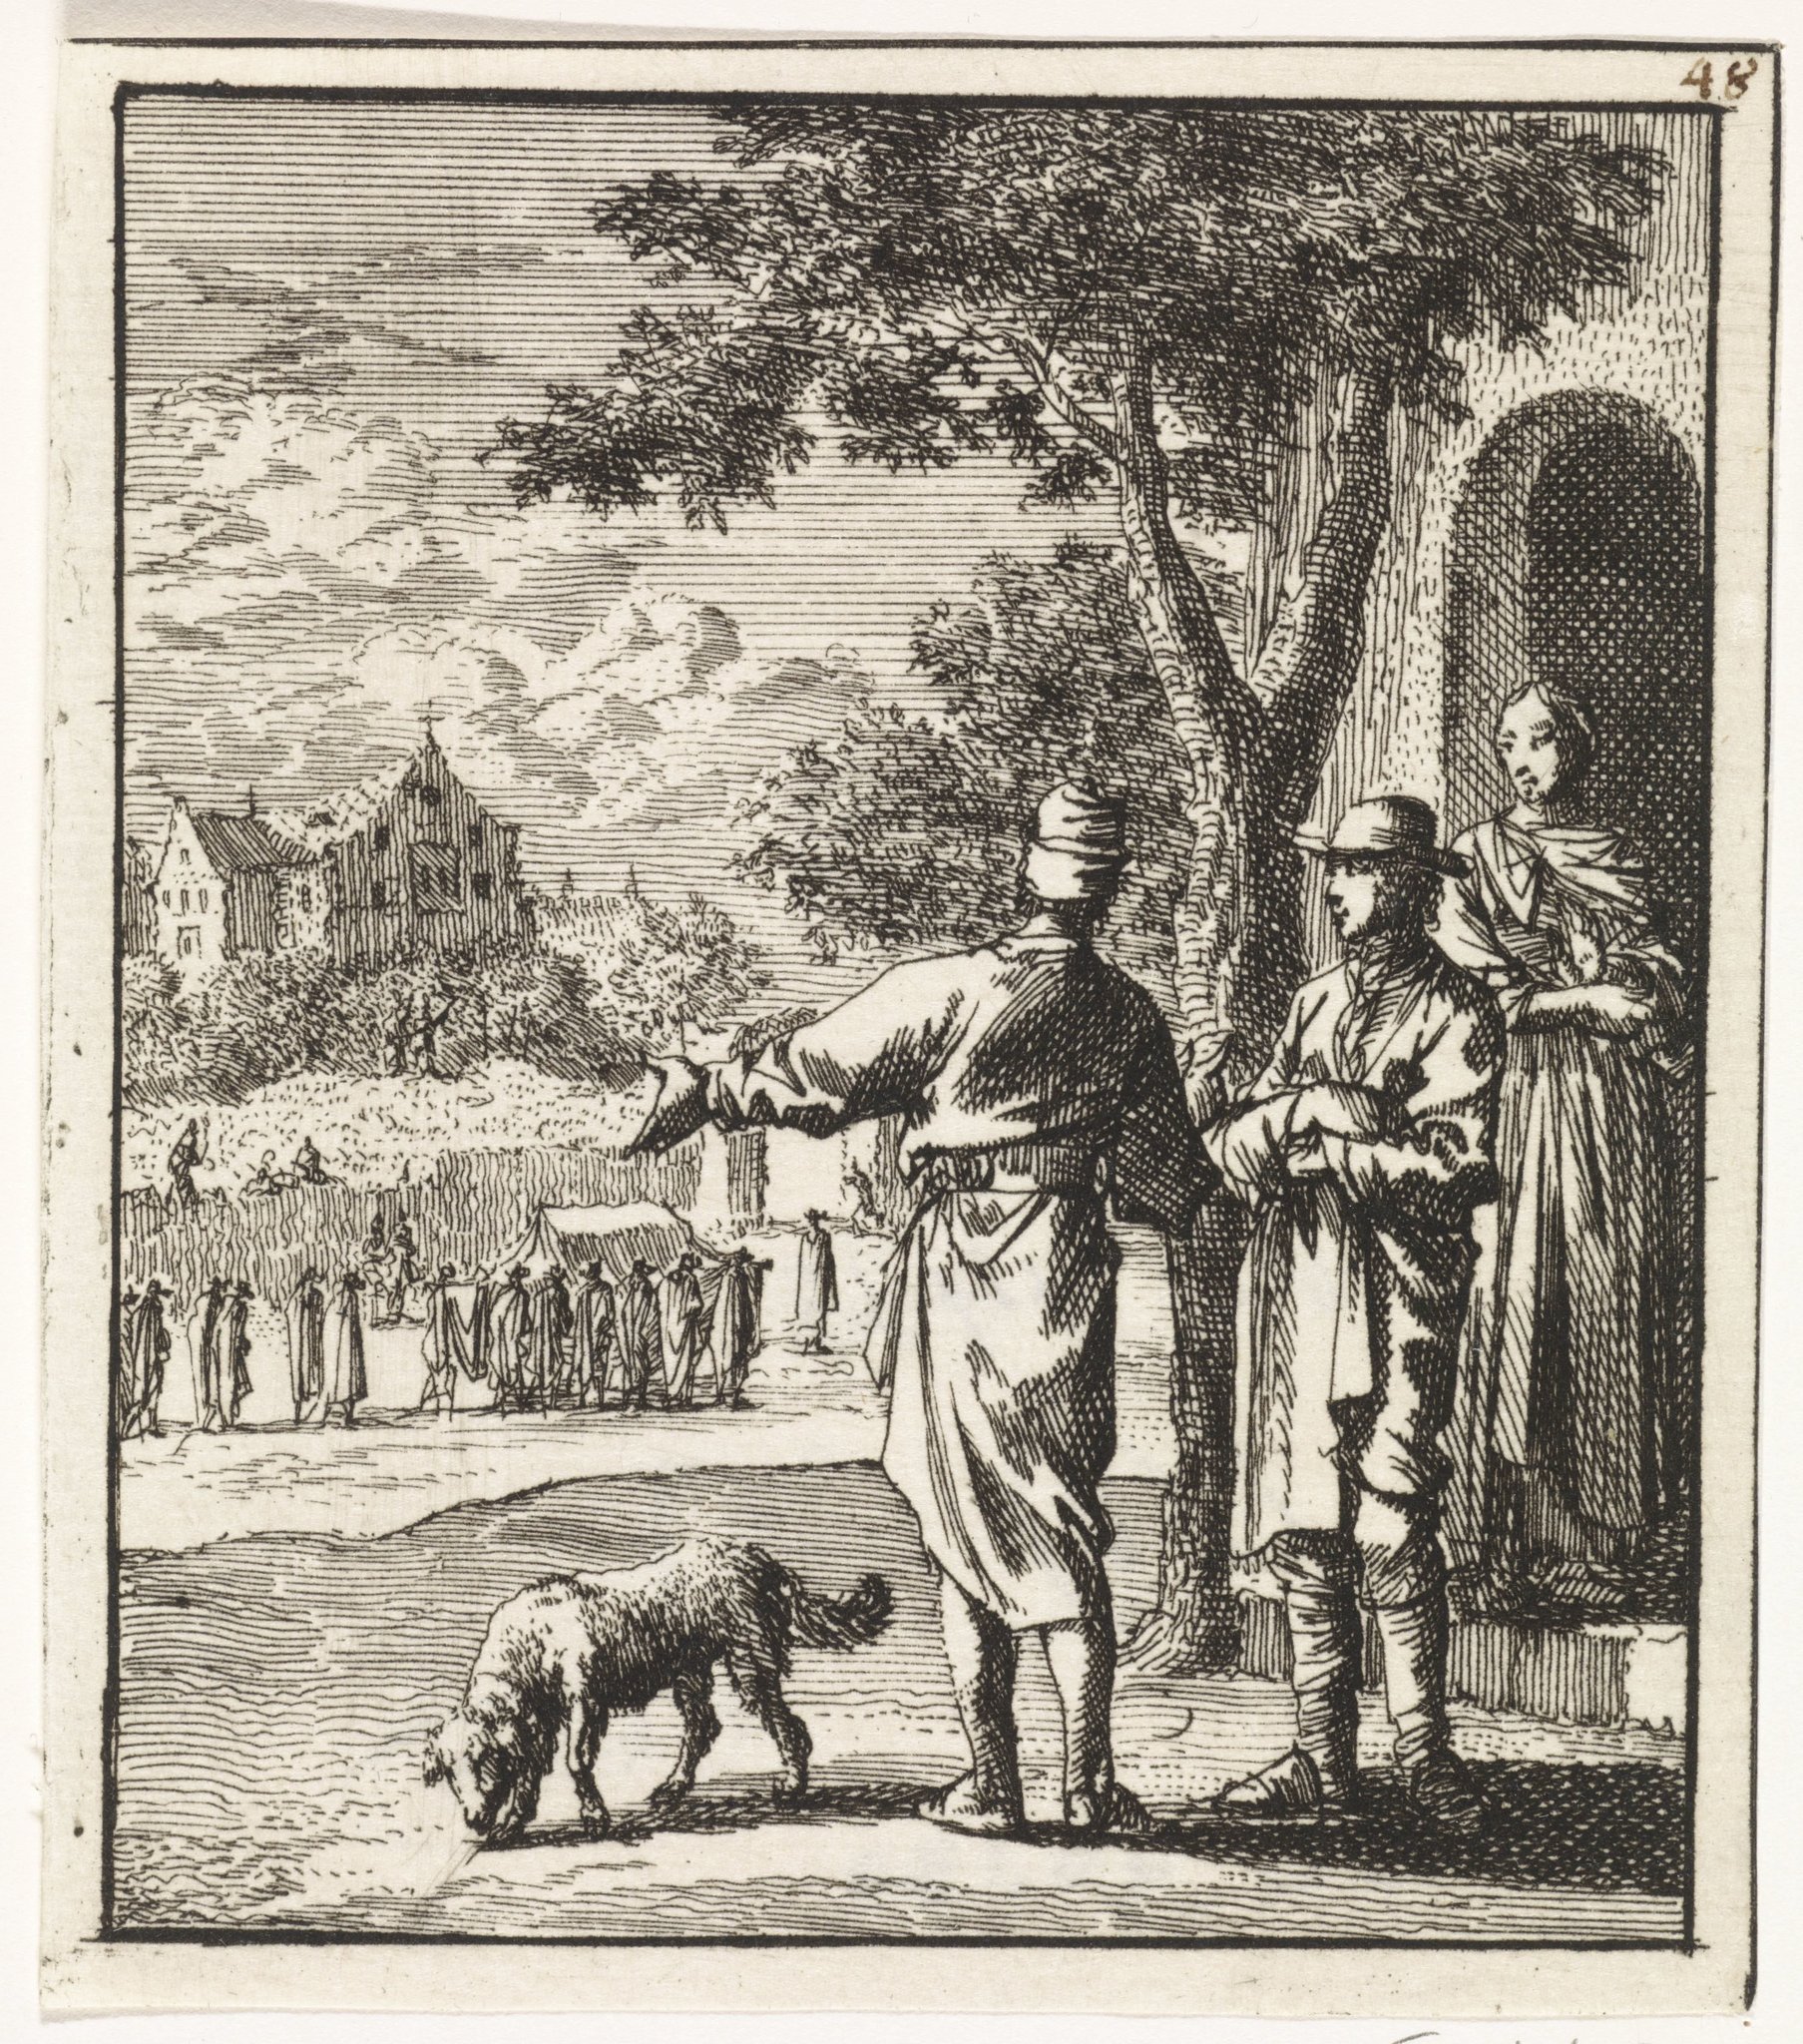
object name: print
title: Twee mannen aanschouwen een voorbijtrekkende rouwstoet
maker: jan luyken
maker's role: draughtsman, print maker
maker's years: 1649-1712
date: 1712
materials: paper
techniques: etching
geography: amsterdam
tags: cortege, funeral procession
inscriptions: collector's mark: Lugt 2228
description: Proefdruk van illustratie uit: Luyken, Jan. Des menschen begin, midden en einde. Amsterdam: Wed. Pieter Arentsz II en Cornelis van der Sys, 1712, p. 99.